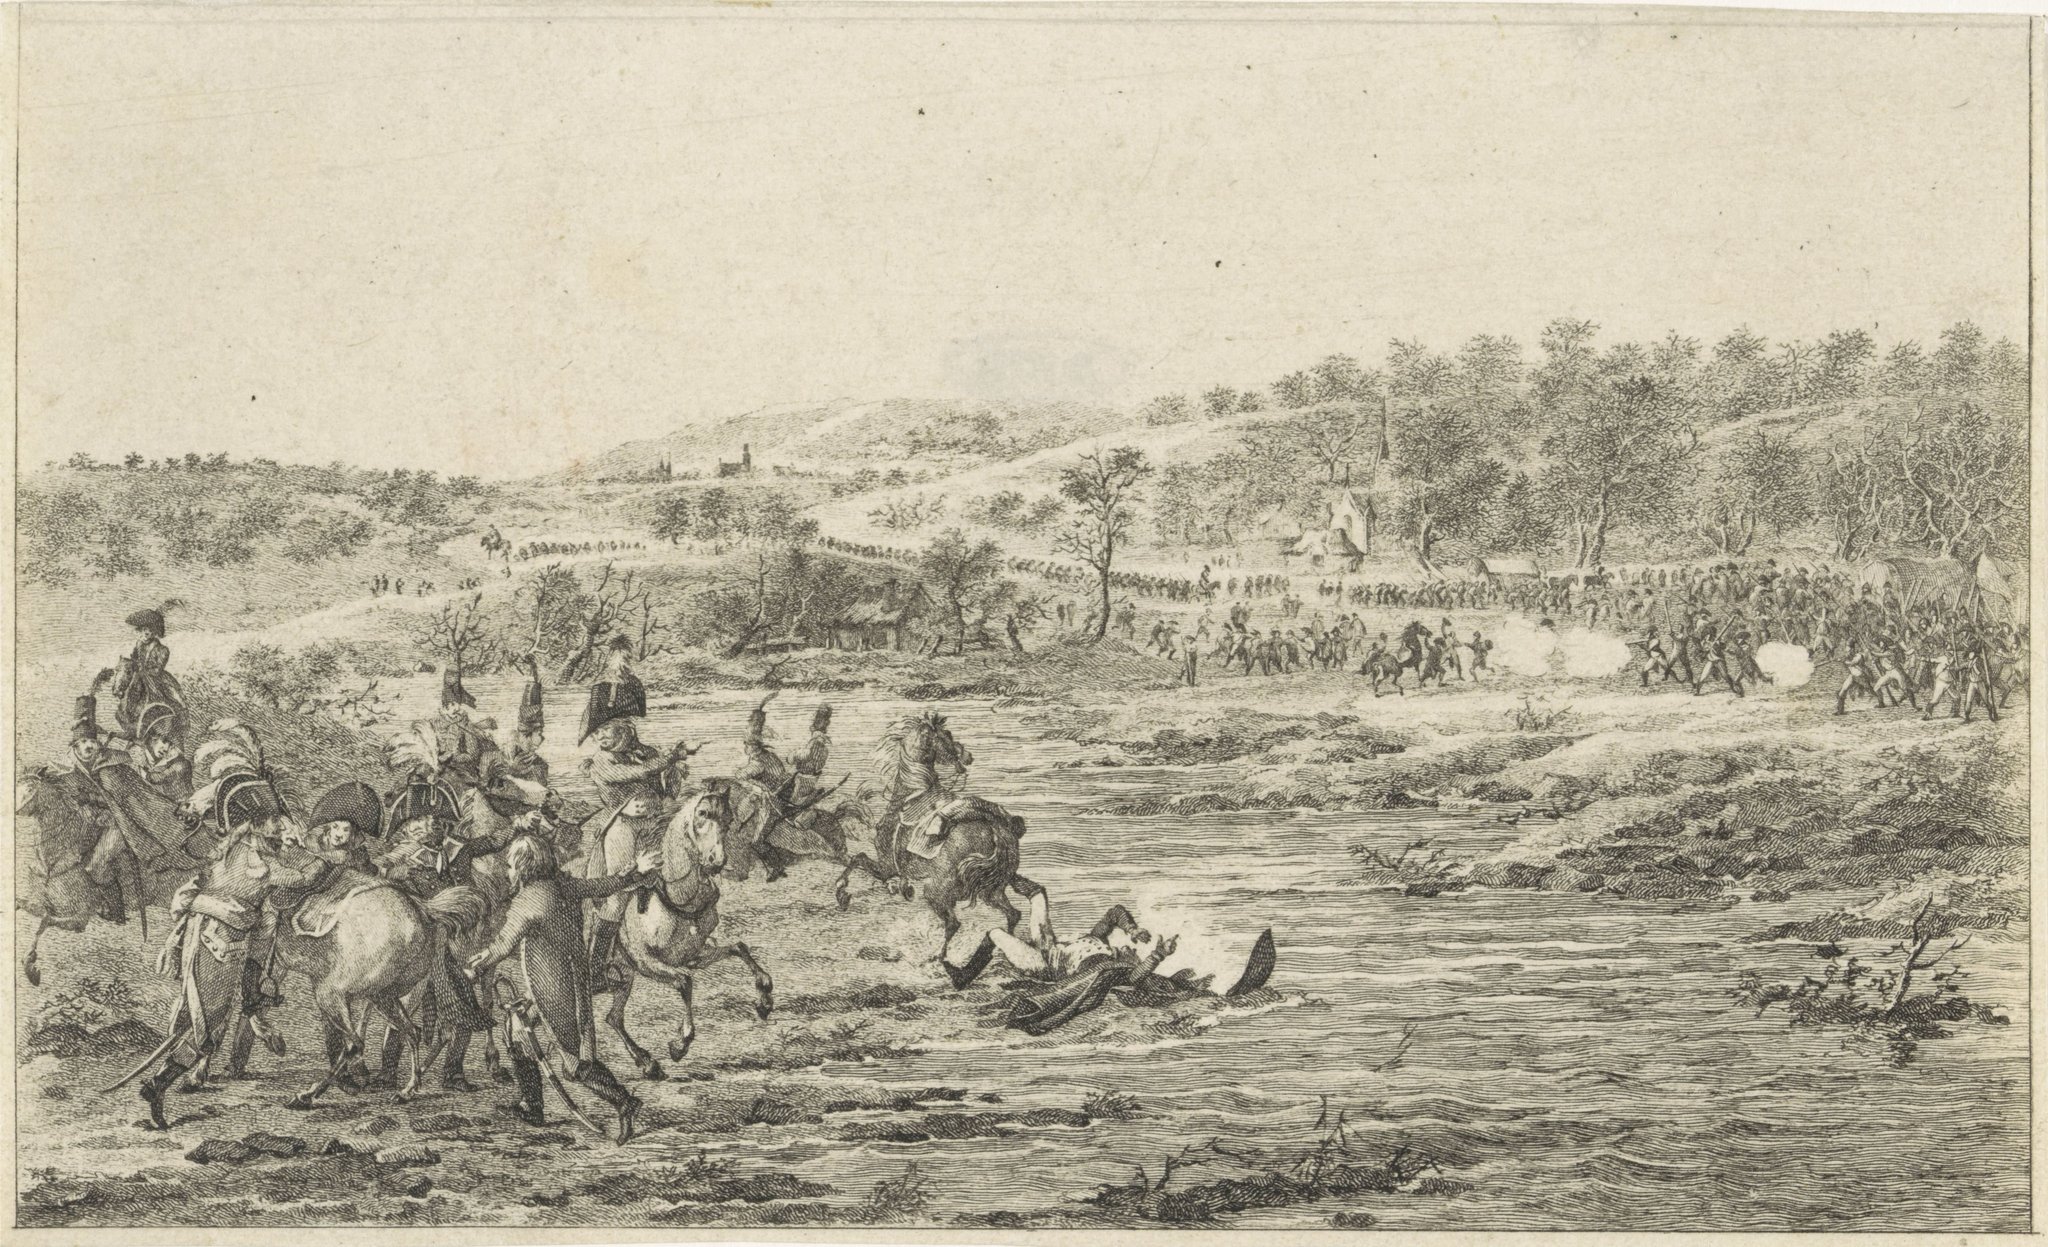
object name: print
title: Vlucht van Dumouriez, 1793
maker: joannes bemme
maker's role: print maker, printer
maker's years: 1775-1841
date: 1793-1795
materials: paper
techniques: etching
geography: northern netherlands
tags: putting the enemy to flight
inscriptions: collector's mark: Lugt 2228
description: Vlucht van de Franse generaal Dumouriez, 4 april 1793. De generaal steekt met een aantal officieren te paard een riviertje over, achterna gezeten en beschoten door een leger aan de overzijde.